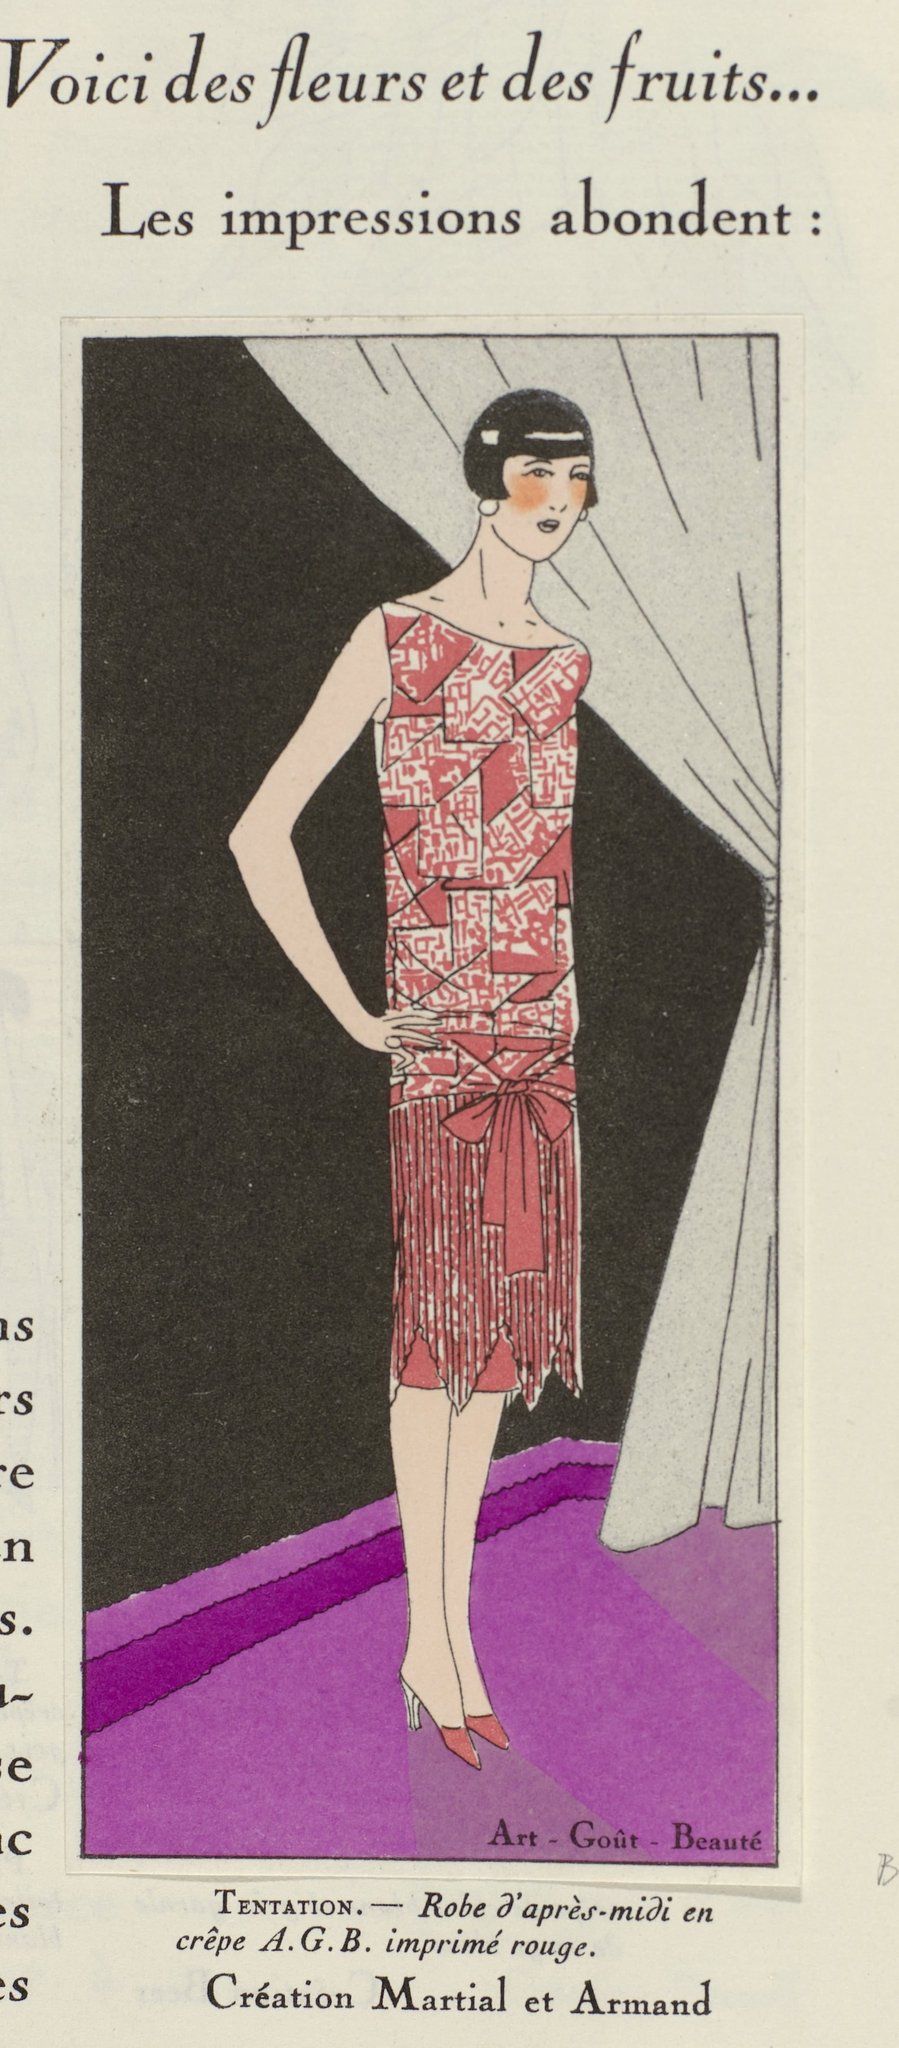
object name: fashion print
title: Art - Goût - Beauté, Feuillets de l' élégance féminine, Février 1926, No. 66, 6e Année, p. 12: Création Martial et Armand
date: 1926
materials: paper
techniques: hand coloring, lithograph, pochoir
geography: paris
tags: ear-rings (+ women's clothes), dress, gown (afternoon dress) (+ women's clothes), fashion plates, necklace (+ women's clothes)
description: Middagjapon van bedrukte rode 'crêpe A.G.B.', van Martial et Armand. Deel van een pagina uit het modetijdschrift Art-Goût-Beauté (1920-1933).